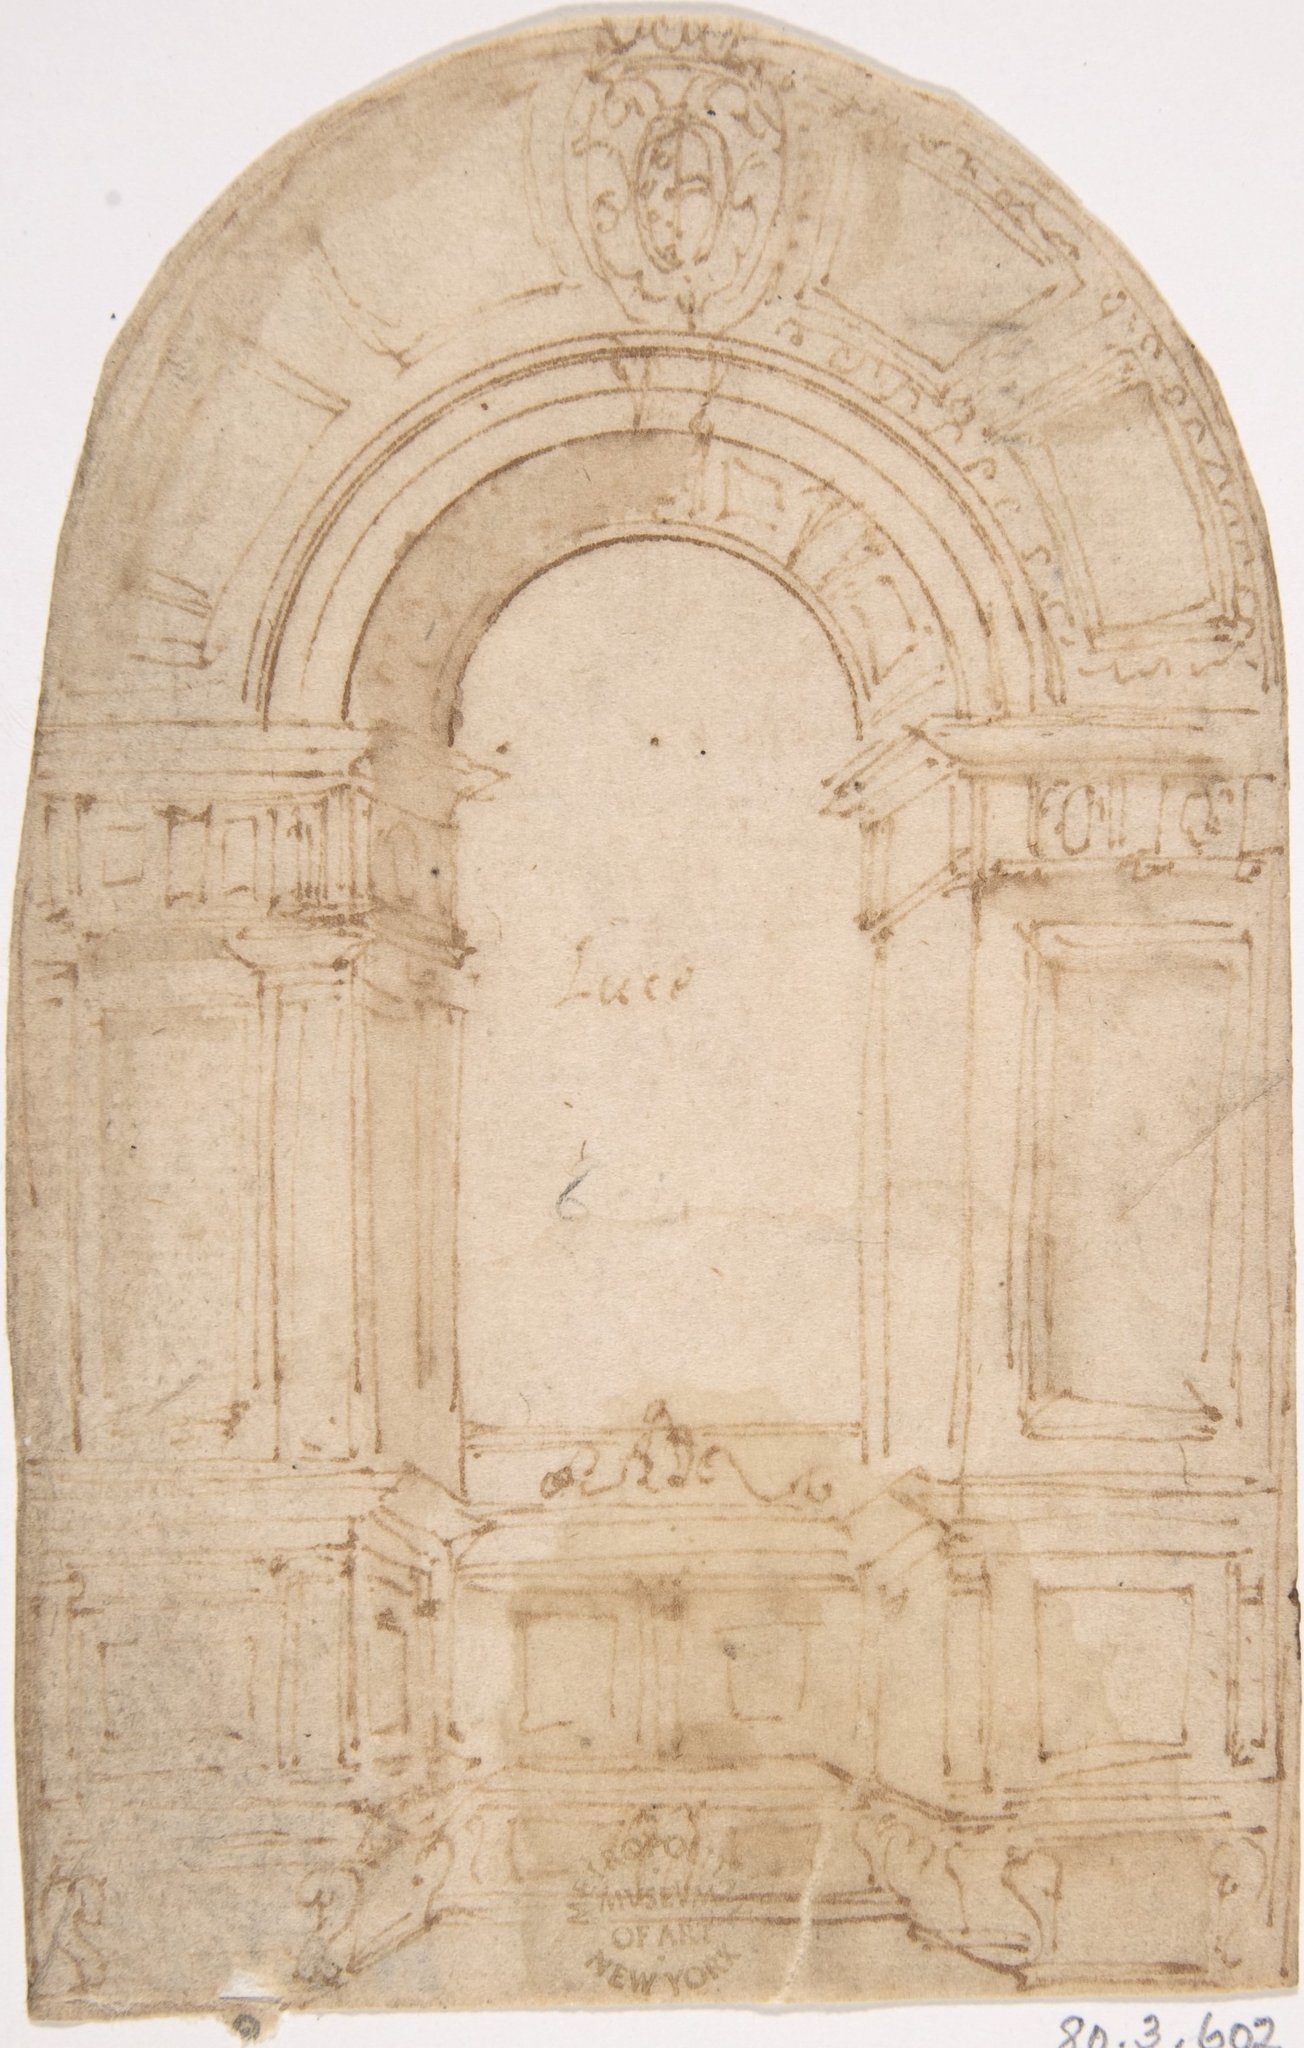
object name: drawing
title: Design for Window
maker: anonymous, italian, 16th century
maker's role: artist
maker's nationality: italian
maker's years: 1550-1600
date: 1501-1600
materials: ink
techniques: pen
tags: arches,windows